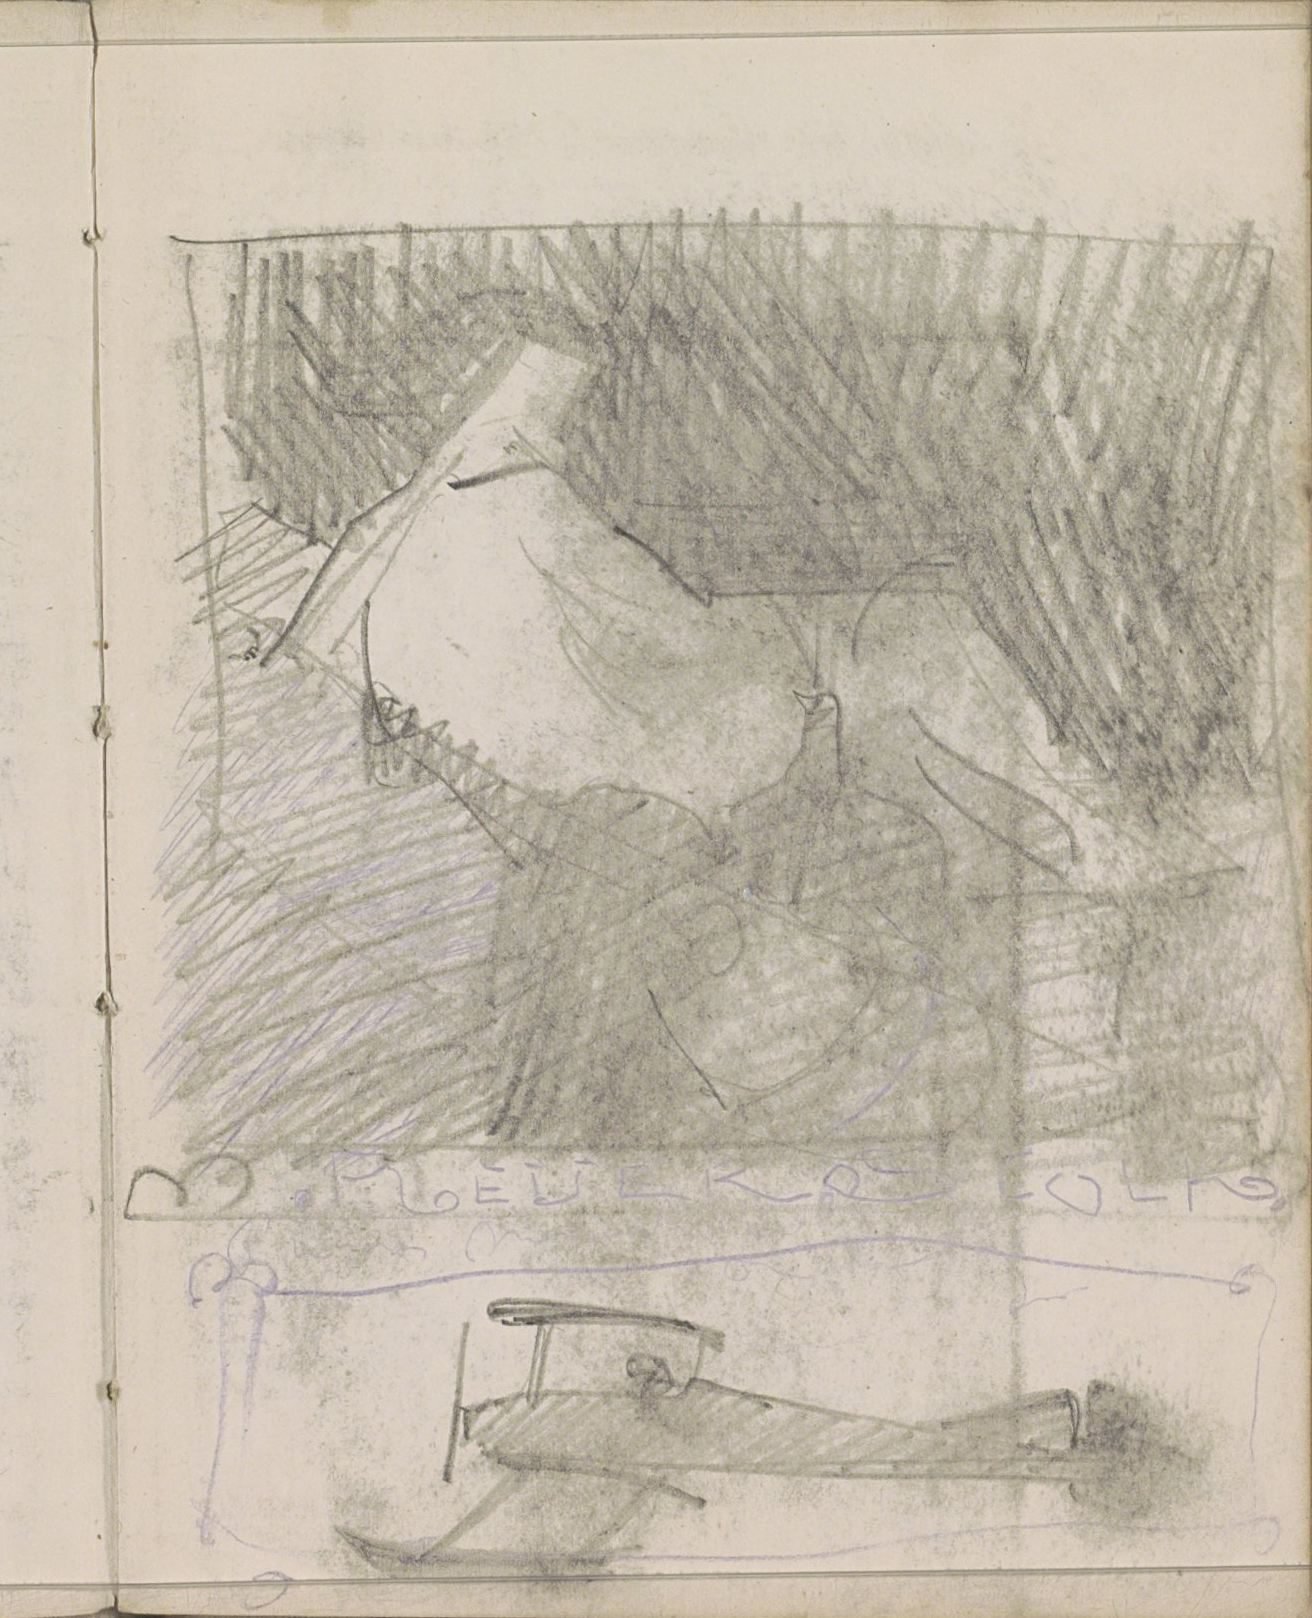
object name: sketchbook leaf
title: Liggende naakte vrouw en een vliegtuig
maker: reijer stolk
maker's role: draughtsman, print maker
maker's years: 1896-1945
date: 1916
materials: paper, pencil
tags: lying figure - aa - female human figure (+ nude human being), aircraft, aeroplane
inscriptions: name: ‘[...]’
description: Blad 2 recto uit een schetsboek met 72 bladen.